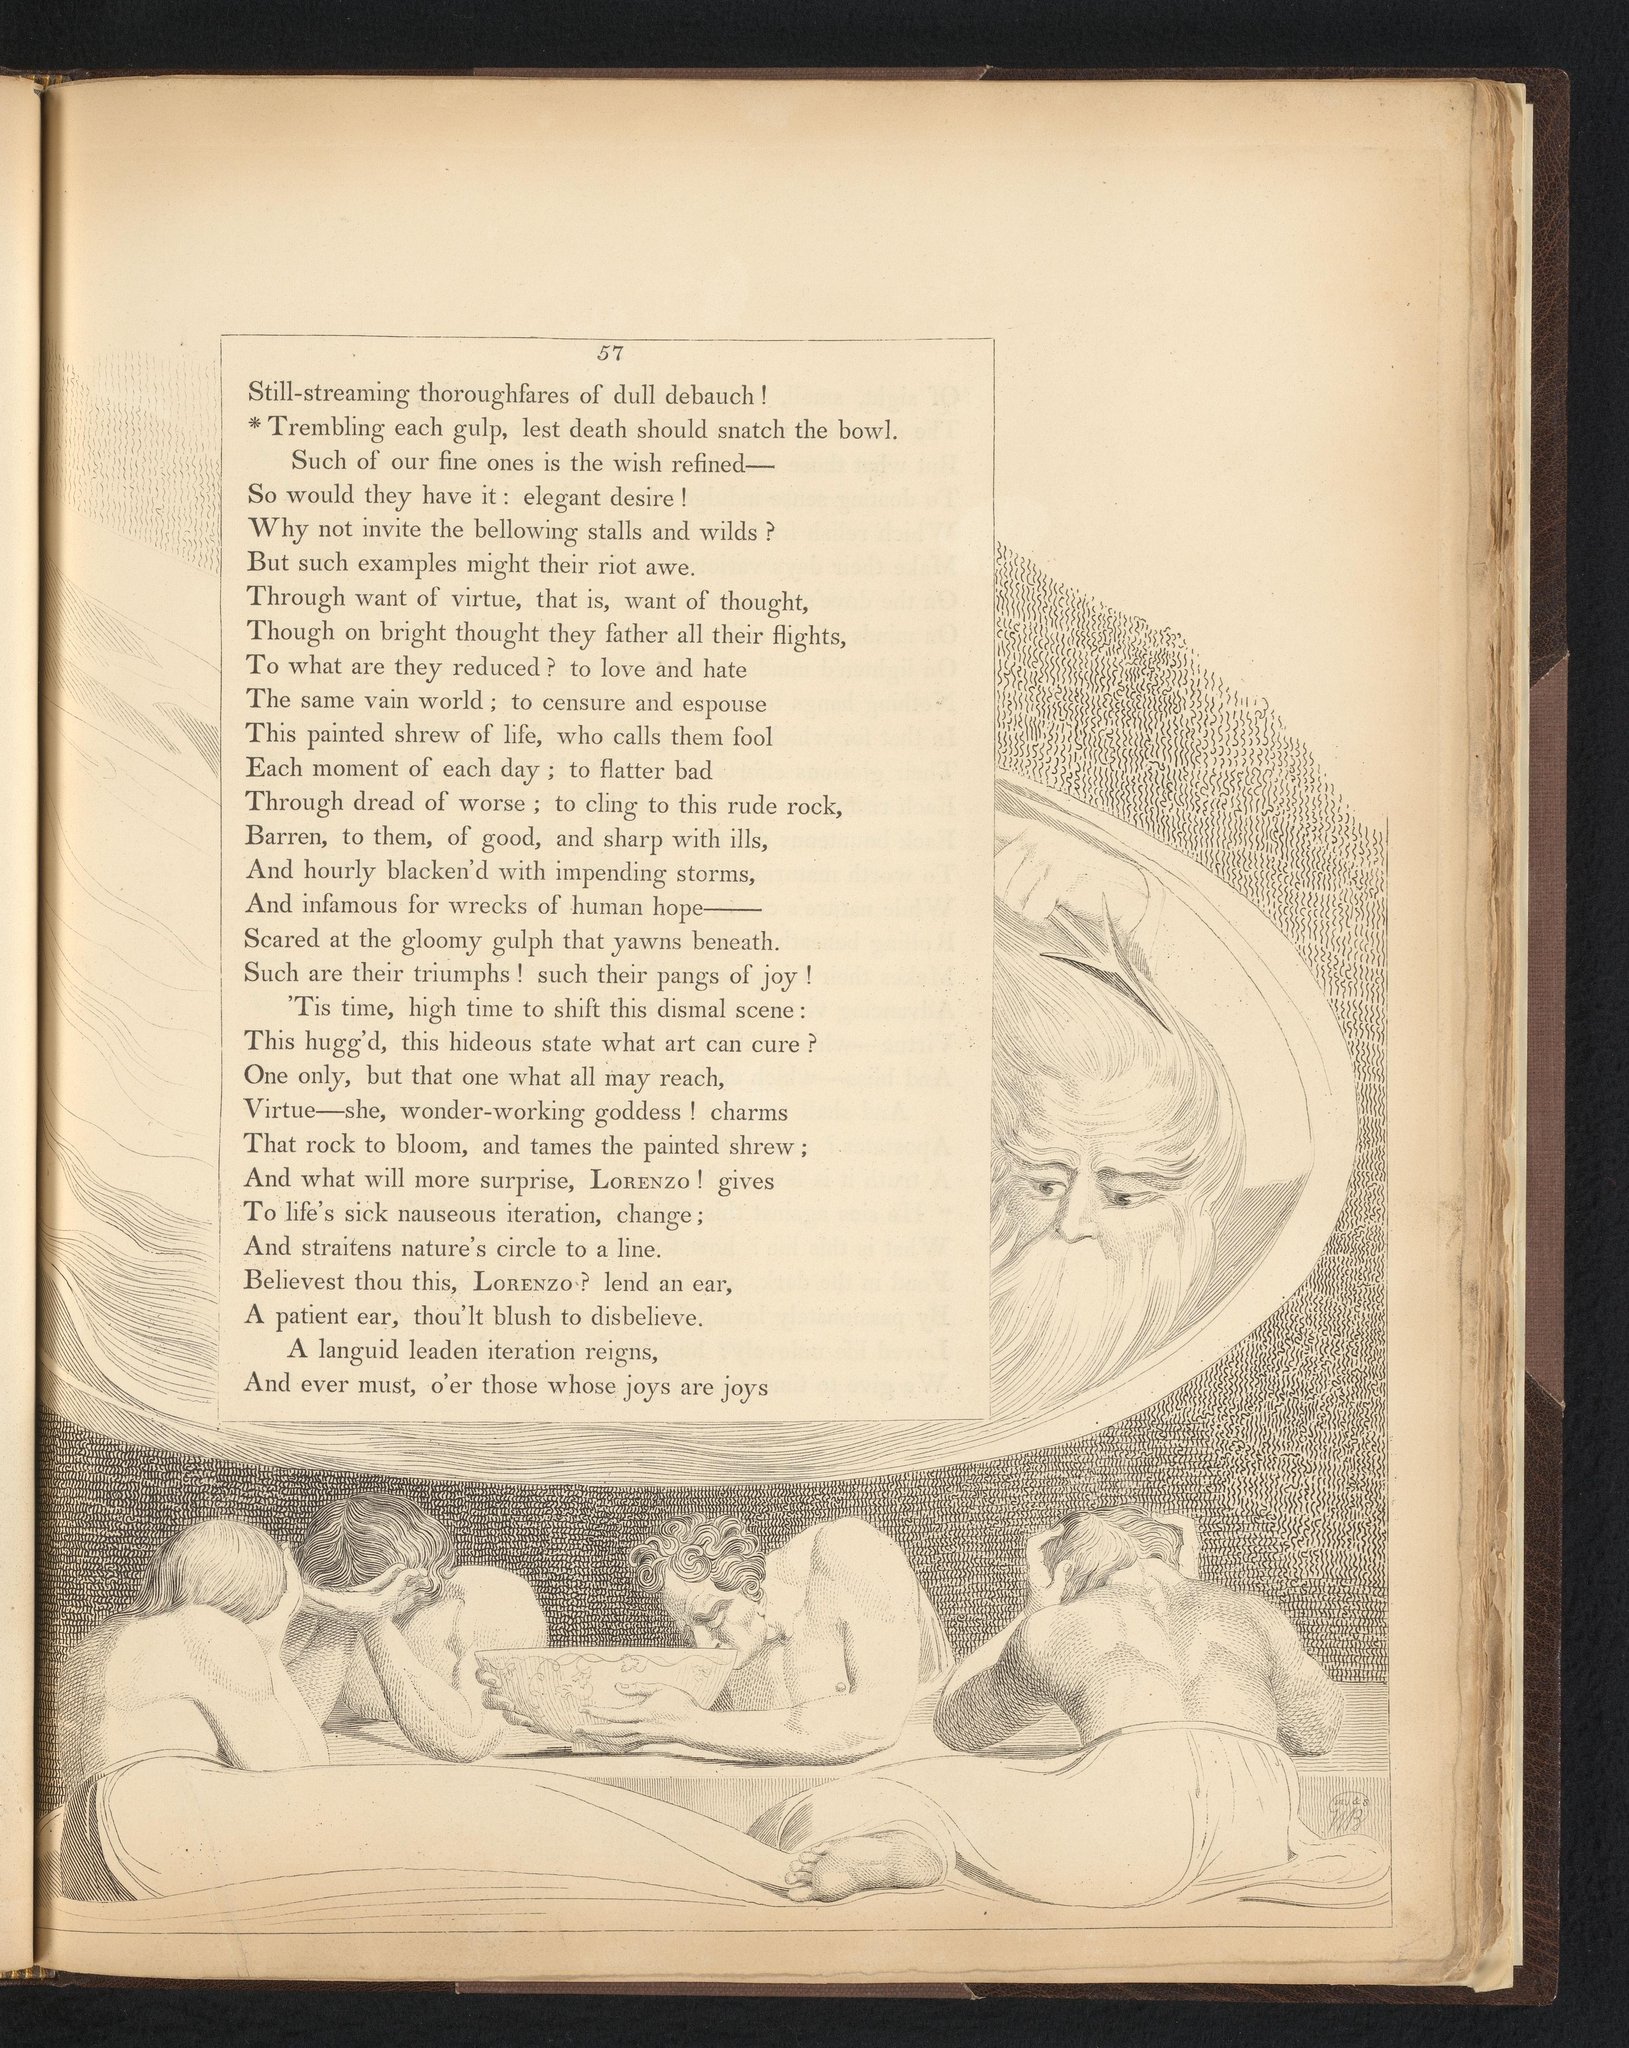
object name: print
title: Vier wenende mannen bekeken door Vadertje Tijd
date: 1796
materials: paper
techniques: engraving, etching, letterpress printing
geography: london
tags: weeping, father time, man with wings and scythe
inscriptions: : ‘Still-streaming thoroughfares of dull debauch ! (...)’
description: Prent maakt deel uit van een boek, bladzijde 57. Tekst in het Engels op het recto en verso.